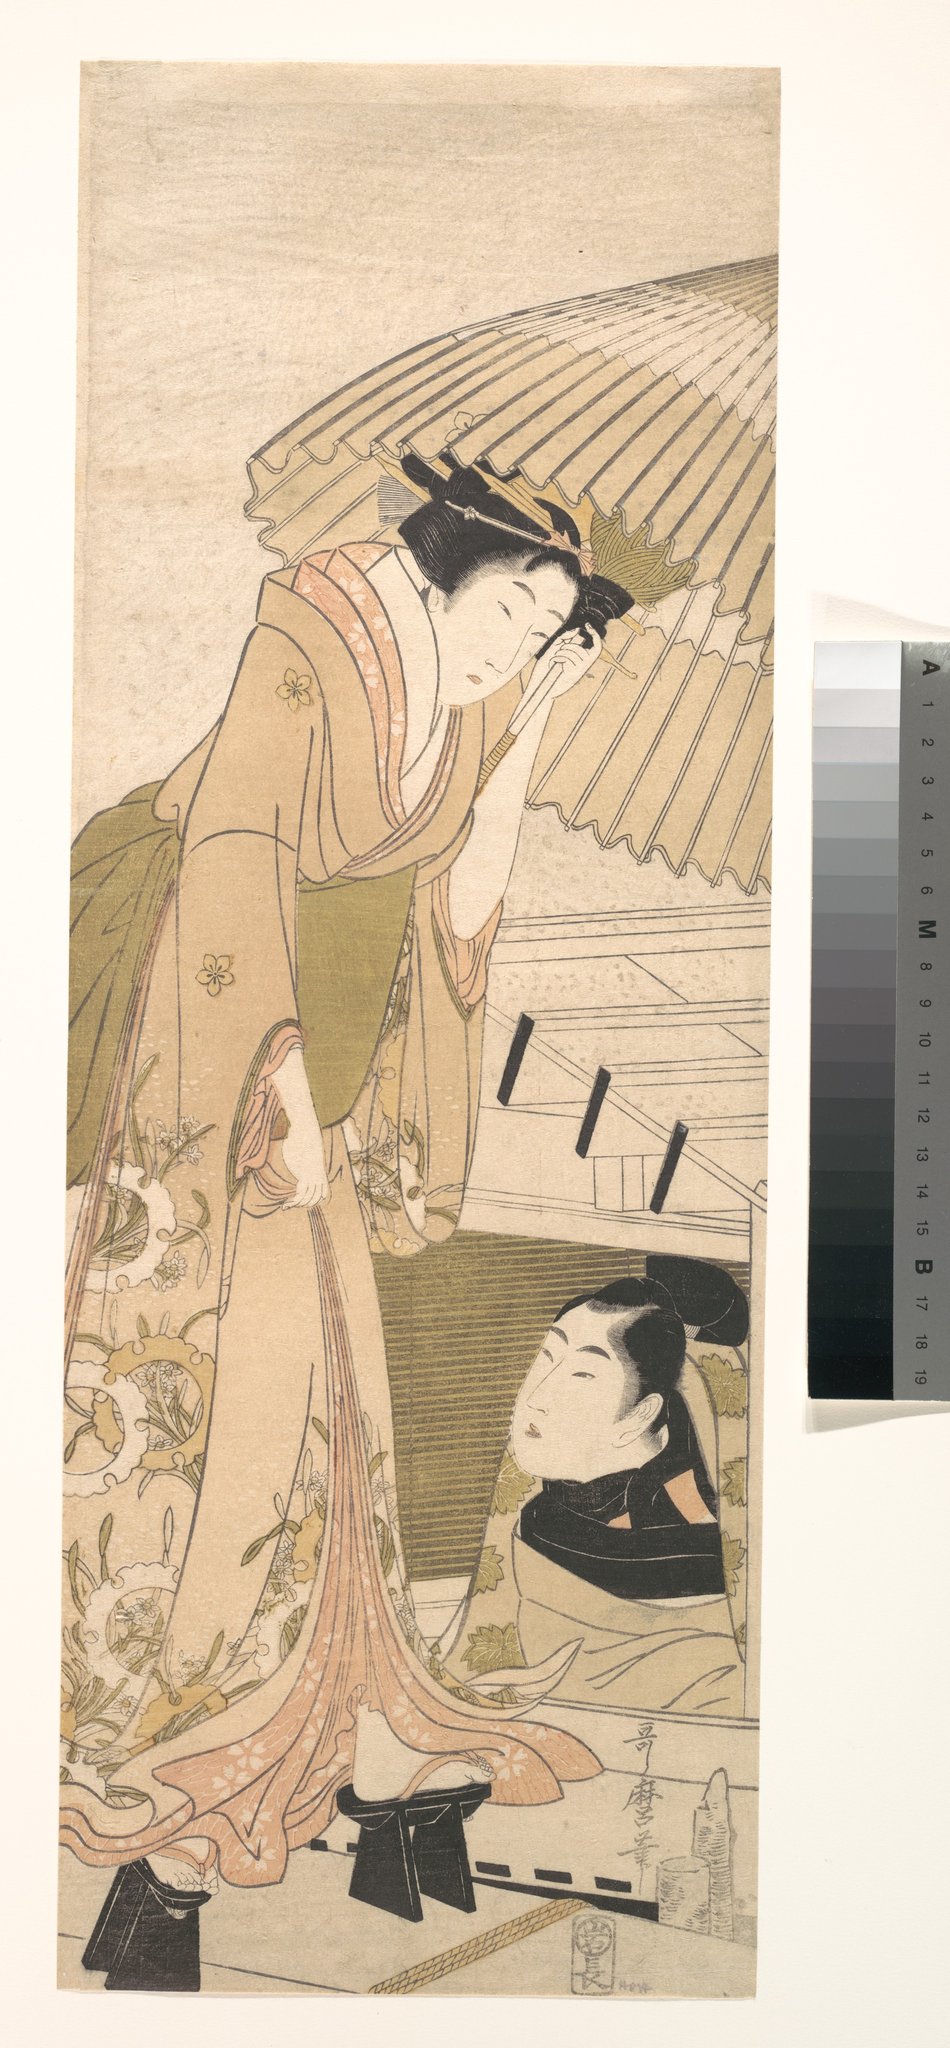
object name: print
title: Landing-stage in the Snow (Yuki no sanbashi)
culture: japanese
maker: kitagawa utamaro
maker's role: artist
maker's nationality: japanese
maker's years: 1754-1806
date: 1800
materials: ink, paper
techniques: woodblock print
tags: women